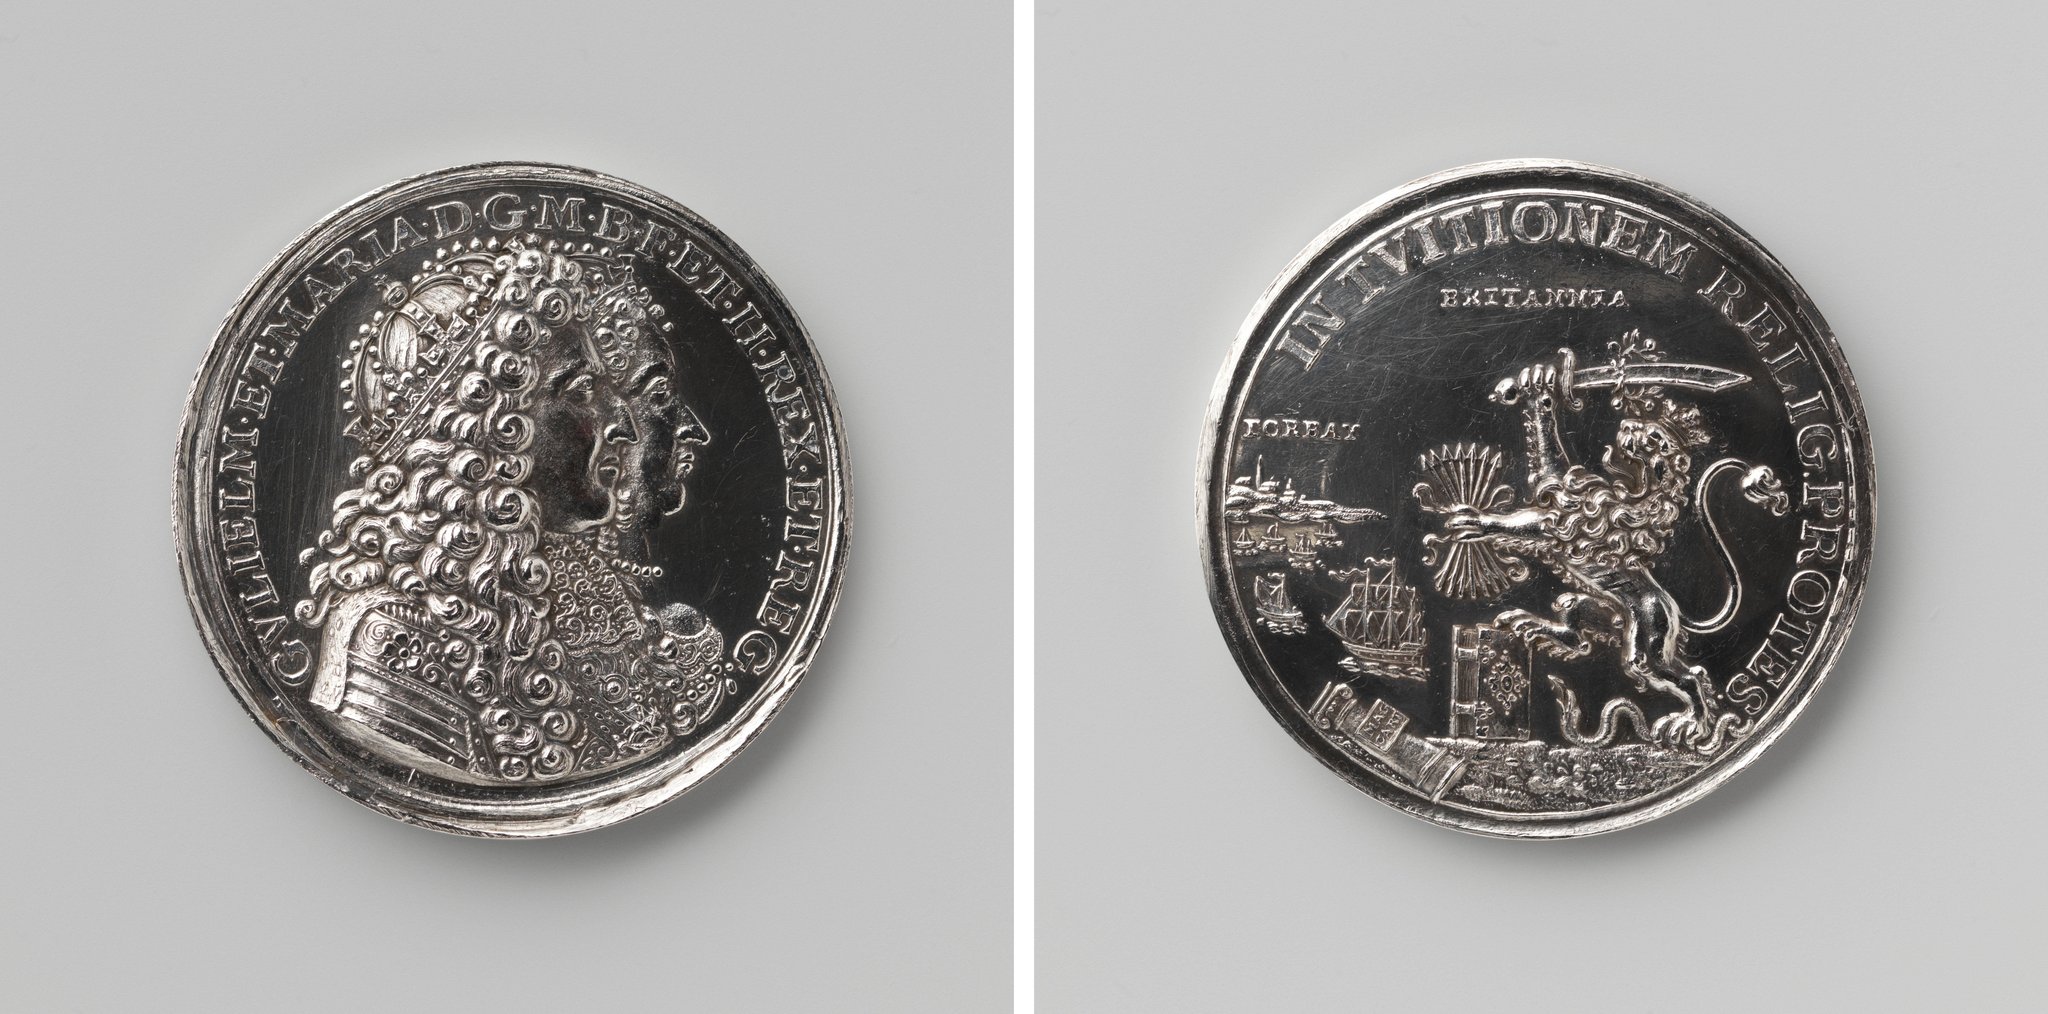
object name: history medal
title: Kroning van Willem III en Maria II Stuart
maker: Anonymous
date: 1689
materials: silver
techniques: striking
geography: netherlands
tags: william iii (prince of orange and king of england, scotland, and ireland), london, maria ii stuart (koningin van engeland, schotland en ierland)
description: Zilveren penning. Voorzijde: borststuk man en vrouw met kroon binnen omschrift. Keerzijde: leeuw met omkranst zwaard en pijlenbundel vertrapt met ene klauw slang en rust met andere op bijbel, op achtergrond landing binnen omschrift